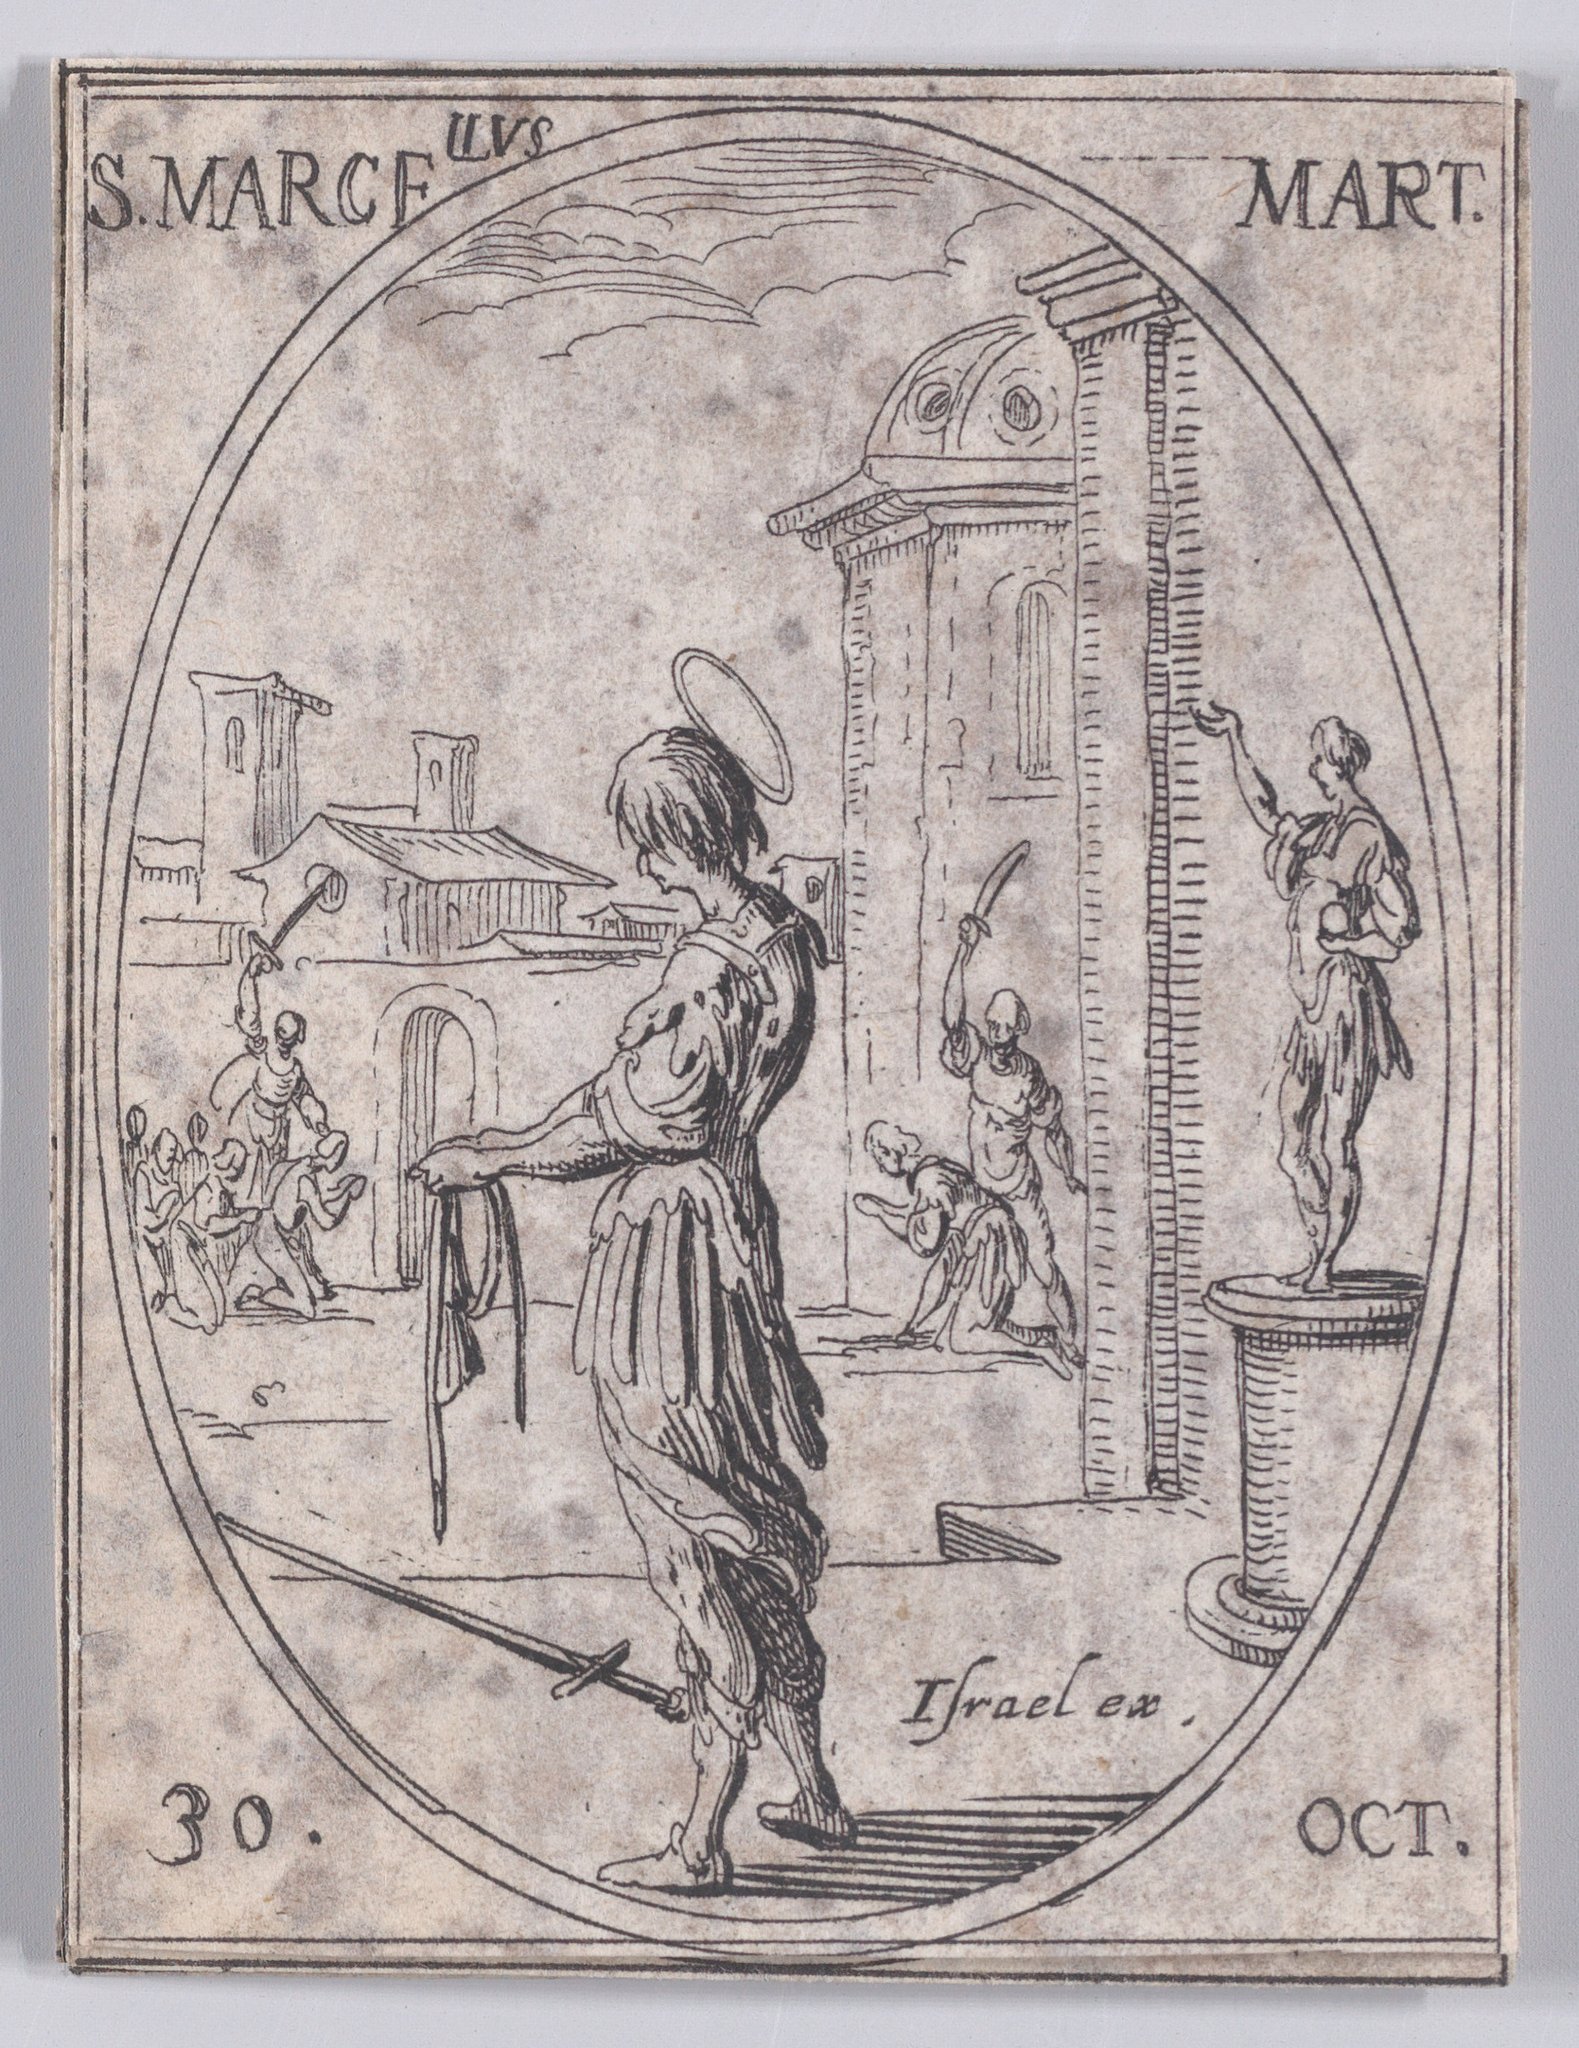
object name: print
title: S. Marcel, martyr (St. Marcellus, Martyr), October 30th, from "Les Images De Tous Les Saincts et Saintes de L'Année" (Images of All of the Saints and Religious Events of the Year)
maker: jacques callot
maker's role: artist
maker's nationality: french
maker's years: 1592-1635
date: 1636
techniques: etching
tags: men,saints